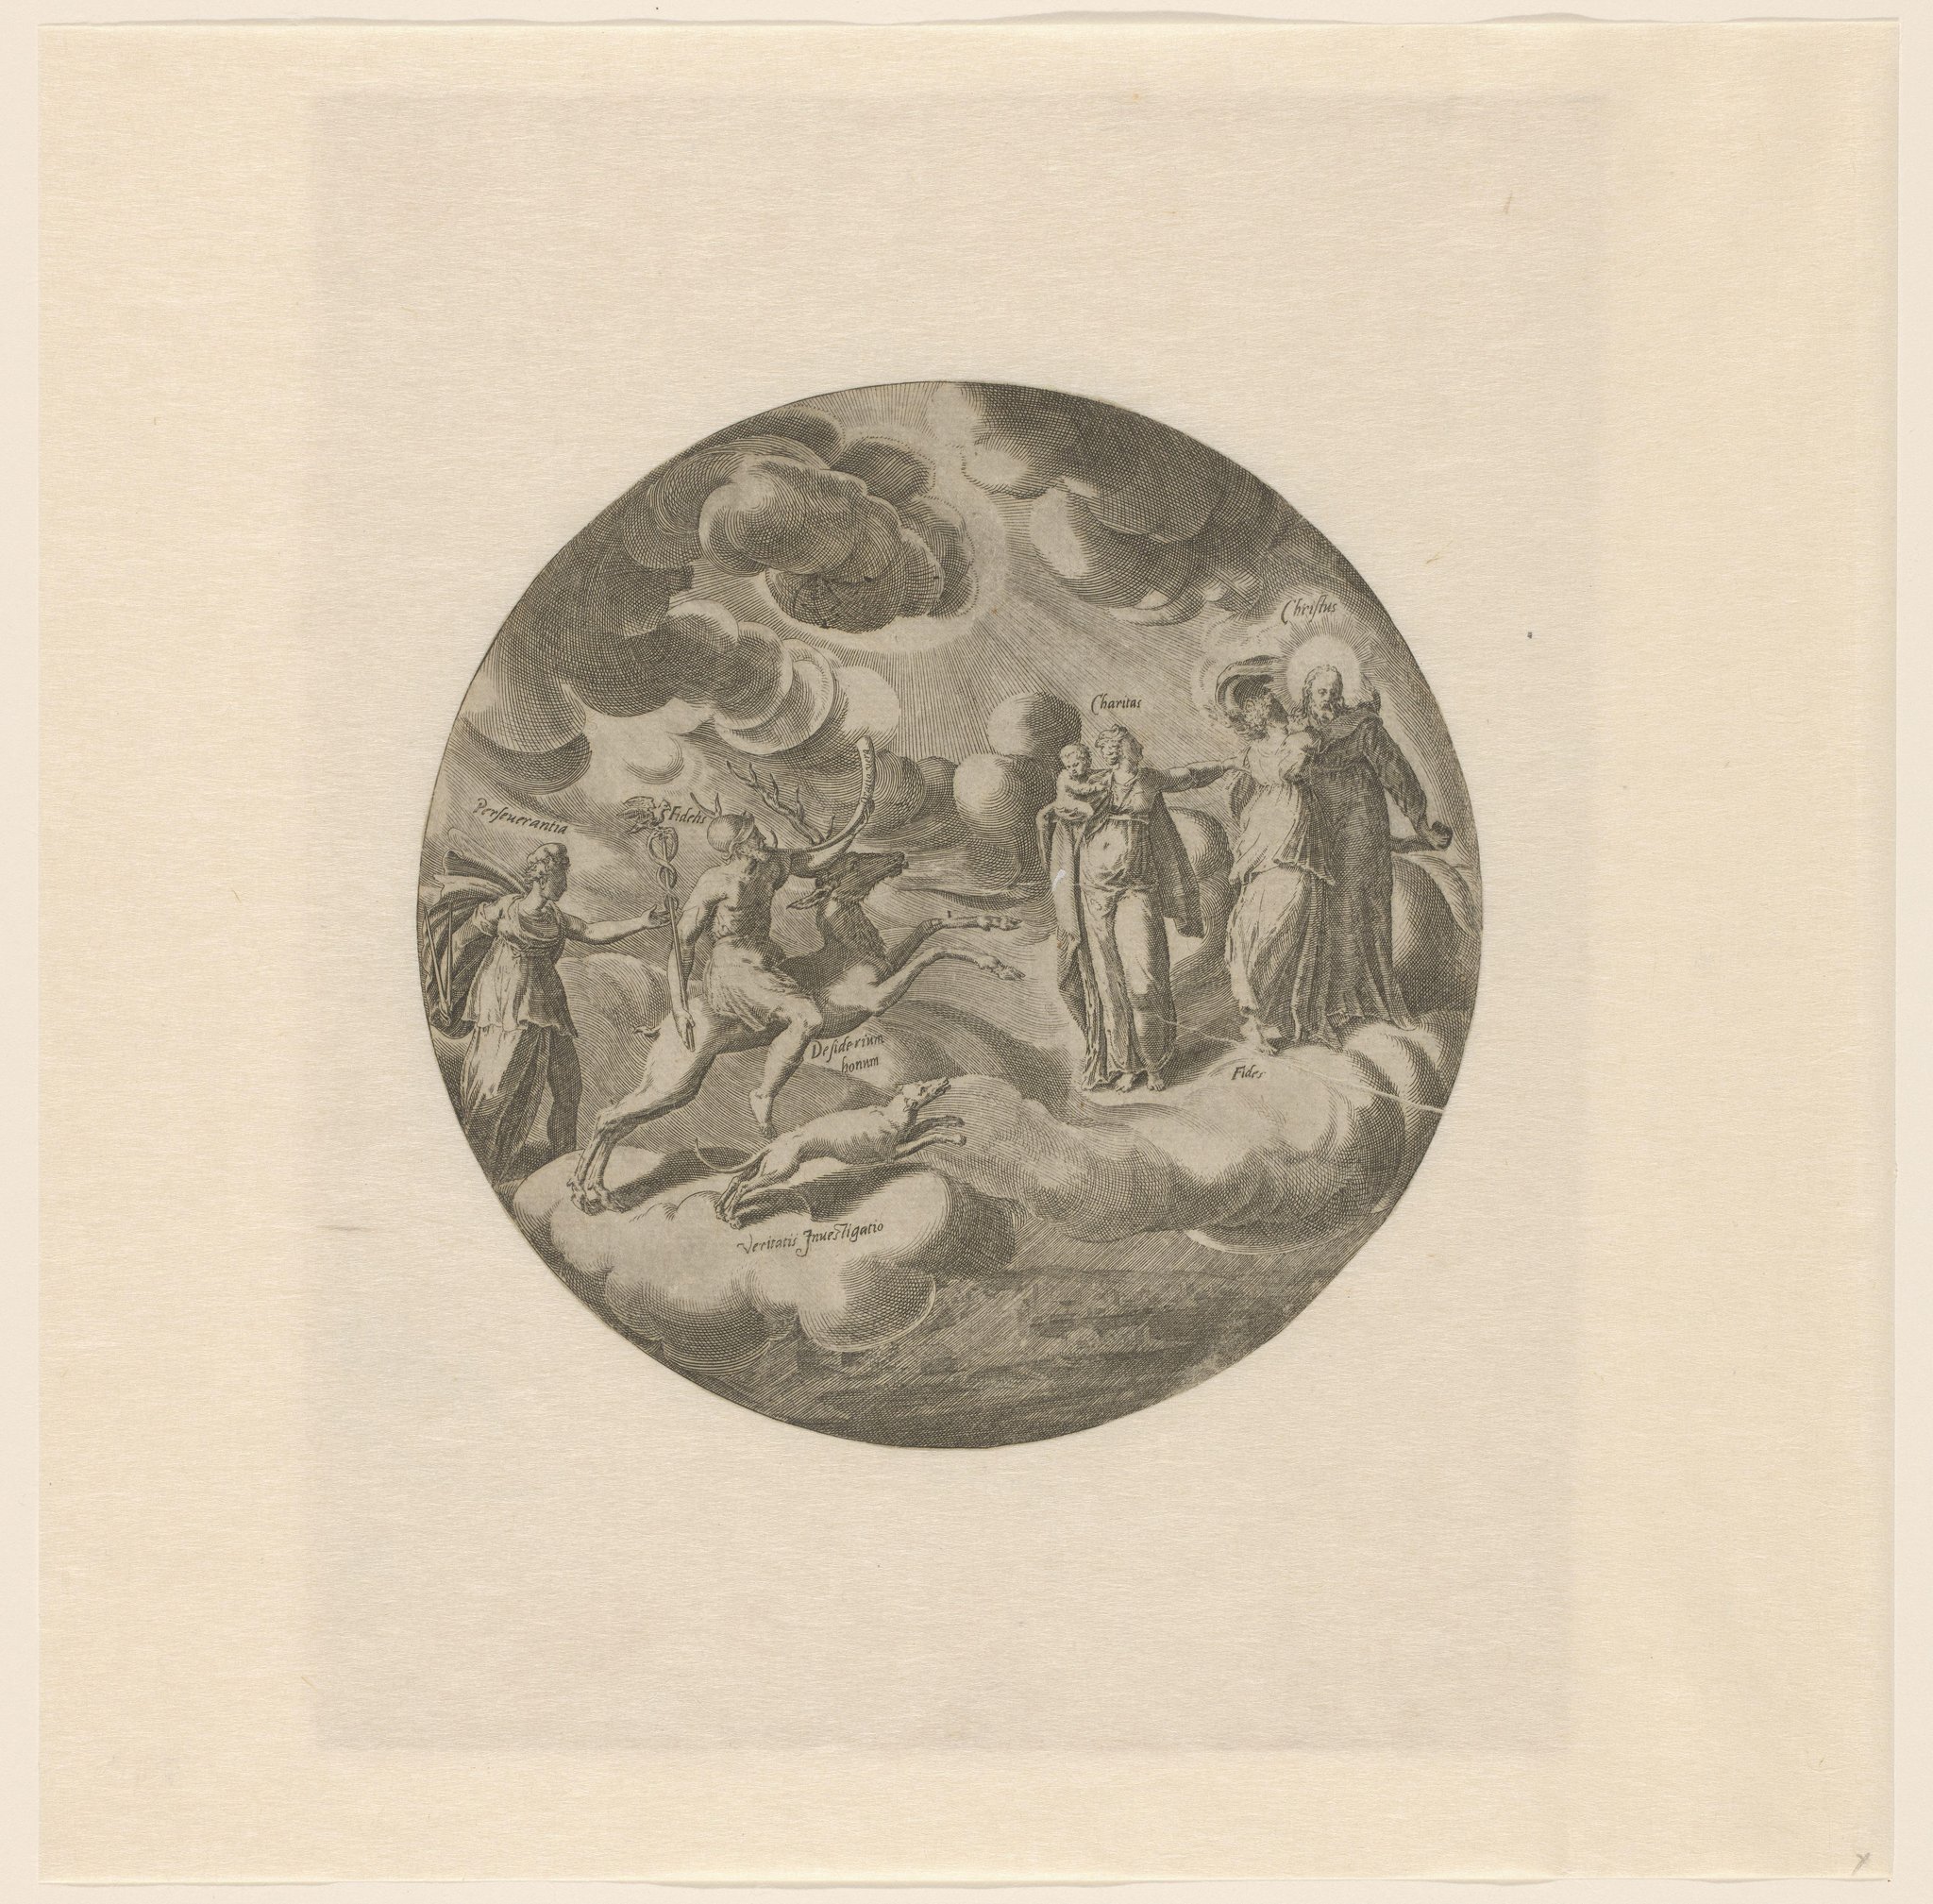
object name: print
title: De jacht naar God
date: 1574-1576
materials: paper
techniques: engraving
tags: perseverance, resolution, determination; 'perseveranza' (ripa) (+ personification), charity, 'caritas'; 'carità' (ripa) ~ one of the three theological virtues, faith, 'fides'; 'fede', 'fede catholica', 'fede christiana', 'fede christiana catholica' (ripa) ~ one of the three theological virtues, hunting dogs, christ as adult, hunters hunting (n.b.: in 1988-1990 this notation denoted the concept of 43c11421 'hunters resting during the hunt'), blowing the hunting horn, the believer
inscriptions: collector's mark: Lugt 2228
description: De prent is hoogstwaarschijnlijk de laatste in een reeks van vier voorstellingen ontworpen door Adriaan de Weerdt die door Van Mander in zijn Schilder-boeck (1604) in het 'Leven' van De Weerdt als volgt wordt beschreven: 'eenighe sinnekens van Coornhert, de vier geestlijcke Jachten gheheeten, d'een jaghende nae giericheyt, d'ander nae oncuysheyt, en soo voort, doch den lesten naer Godt. Den plaet-snijder was oock een seer goet Meester: summa, alle die dingen staen heel op de manier van Francisco Mazzoli van Parma.' (Zie H. Miedema, Karel van Mander. The Lives, 1994-1999, dl. I, p. 178, III, p. 209). Ilja Veldman publiceerde eerder een allegorische reeks (Kupferstichkabinett Dresden), die enigszins overeen leek te komen met Van Manders beschrijving, bestaande uit twee prenten gegraveerd door Coornhert en twee die zijn toegeschreven aan de jonge Hendrick Goltzius. Echter, deze nieuw ontdekte gravure beantwoordt echter zo sterk aan de beschrijving van Van Mander dat het nauwelijks twijfel lijdt dat het laatste in de door hem genoemde reeks Geestelijke Jachten betreft.